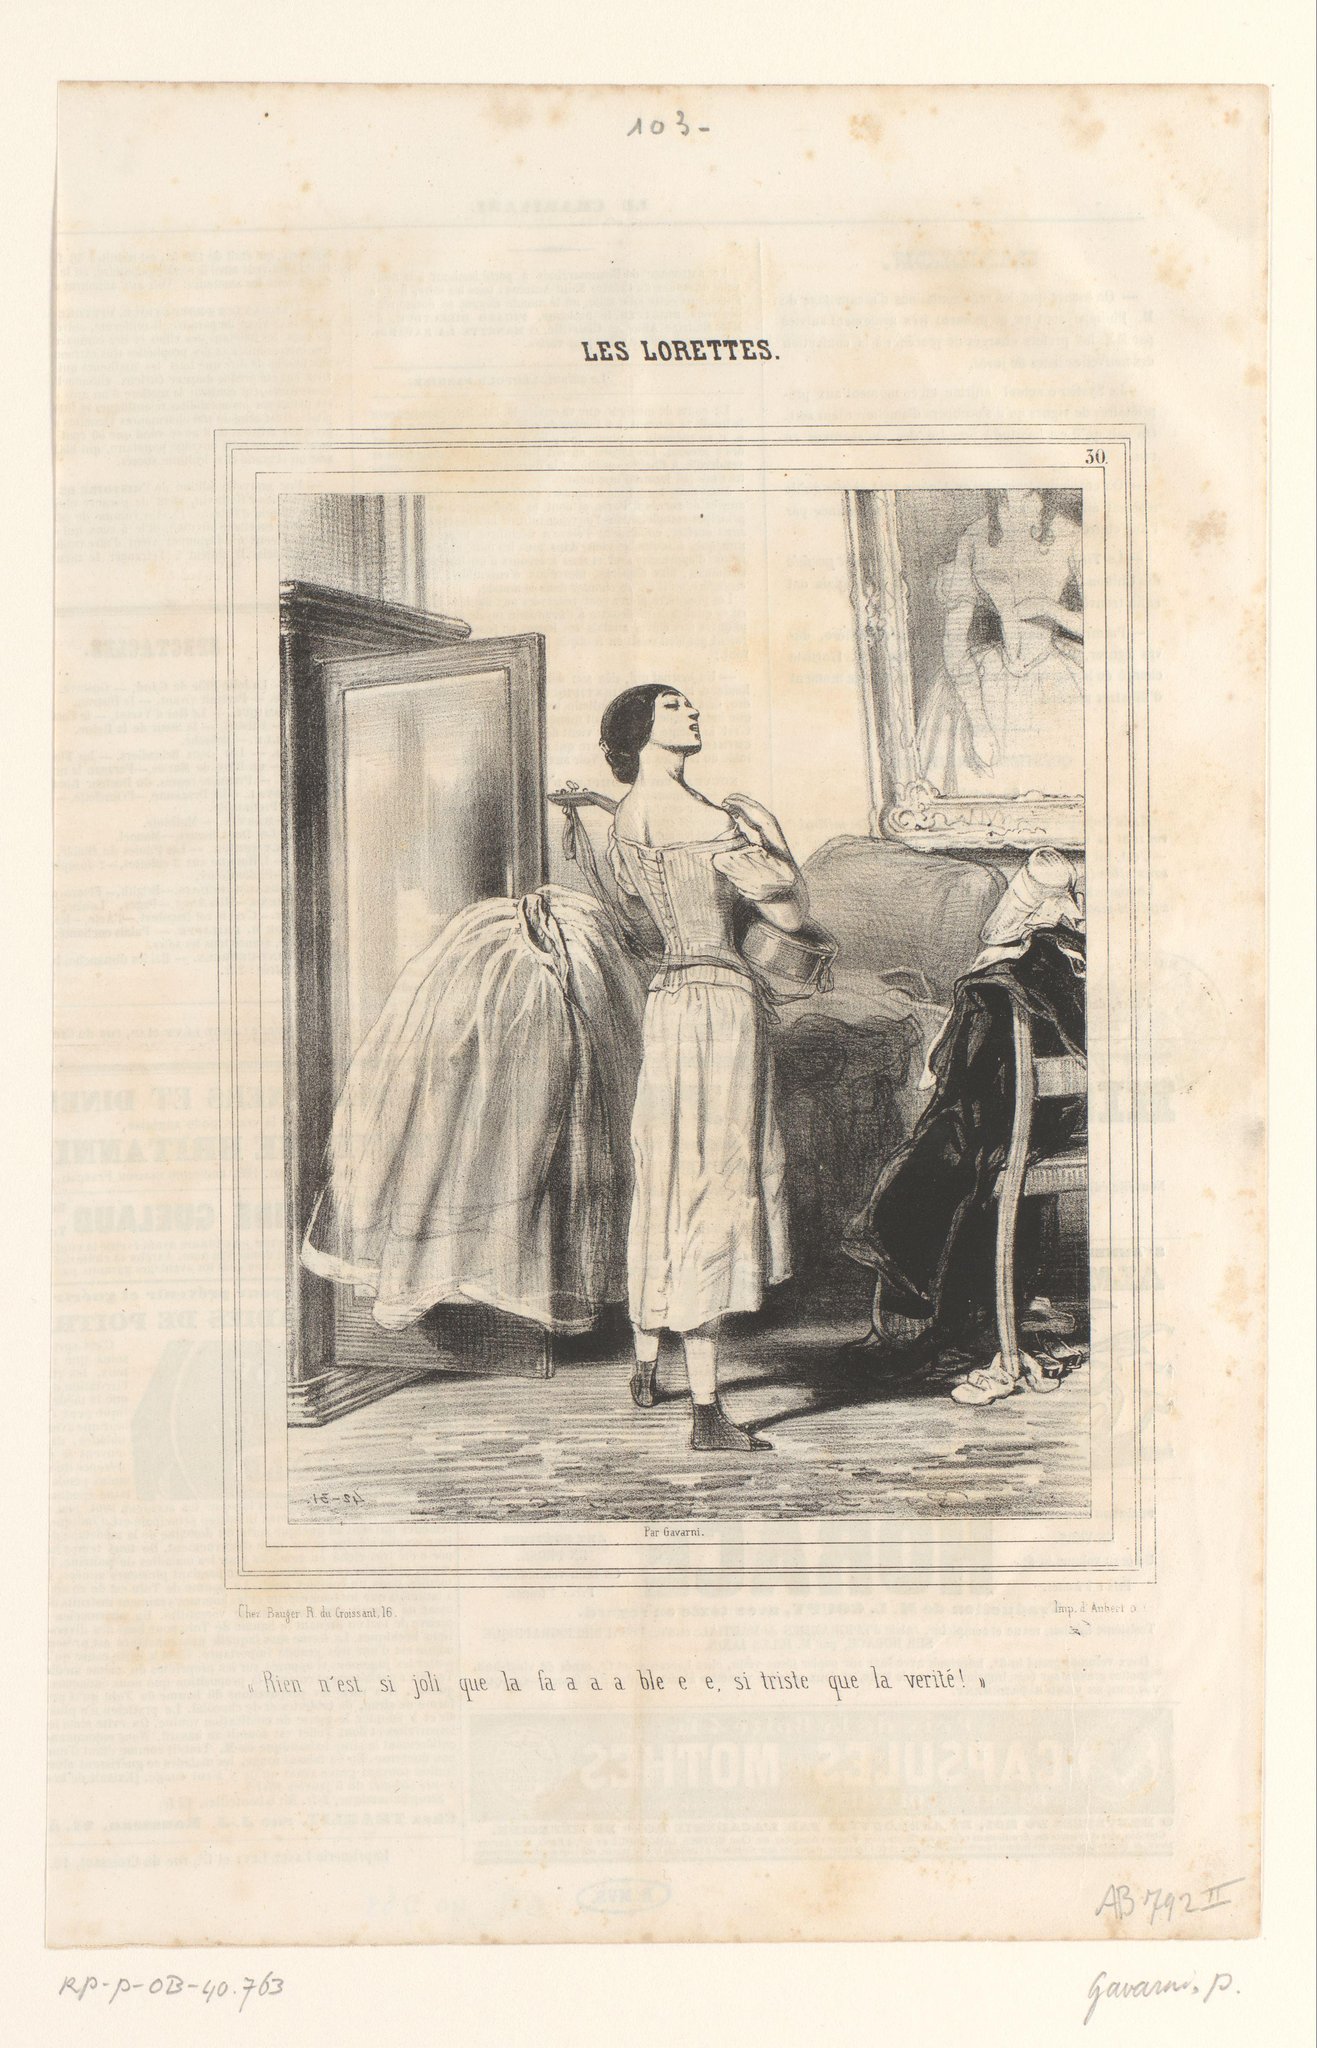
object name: cartoon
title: Rien n'est si joli que la faaaableee (...)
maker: paul gavarni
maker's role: draughtsman, print maker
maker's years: 1804-1866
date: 1842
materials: paper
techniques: lithograph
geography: paris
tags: underclothes for the whole body, female singer, cithern, mandolin, guitar, balalaika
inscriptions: stamp: ‘Timbre Royal/ 3c./ Seine’, collector's mark: Lugt 2228a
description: Prent gebruikt voor: Le Charivari, 21 oktober 1842.